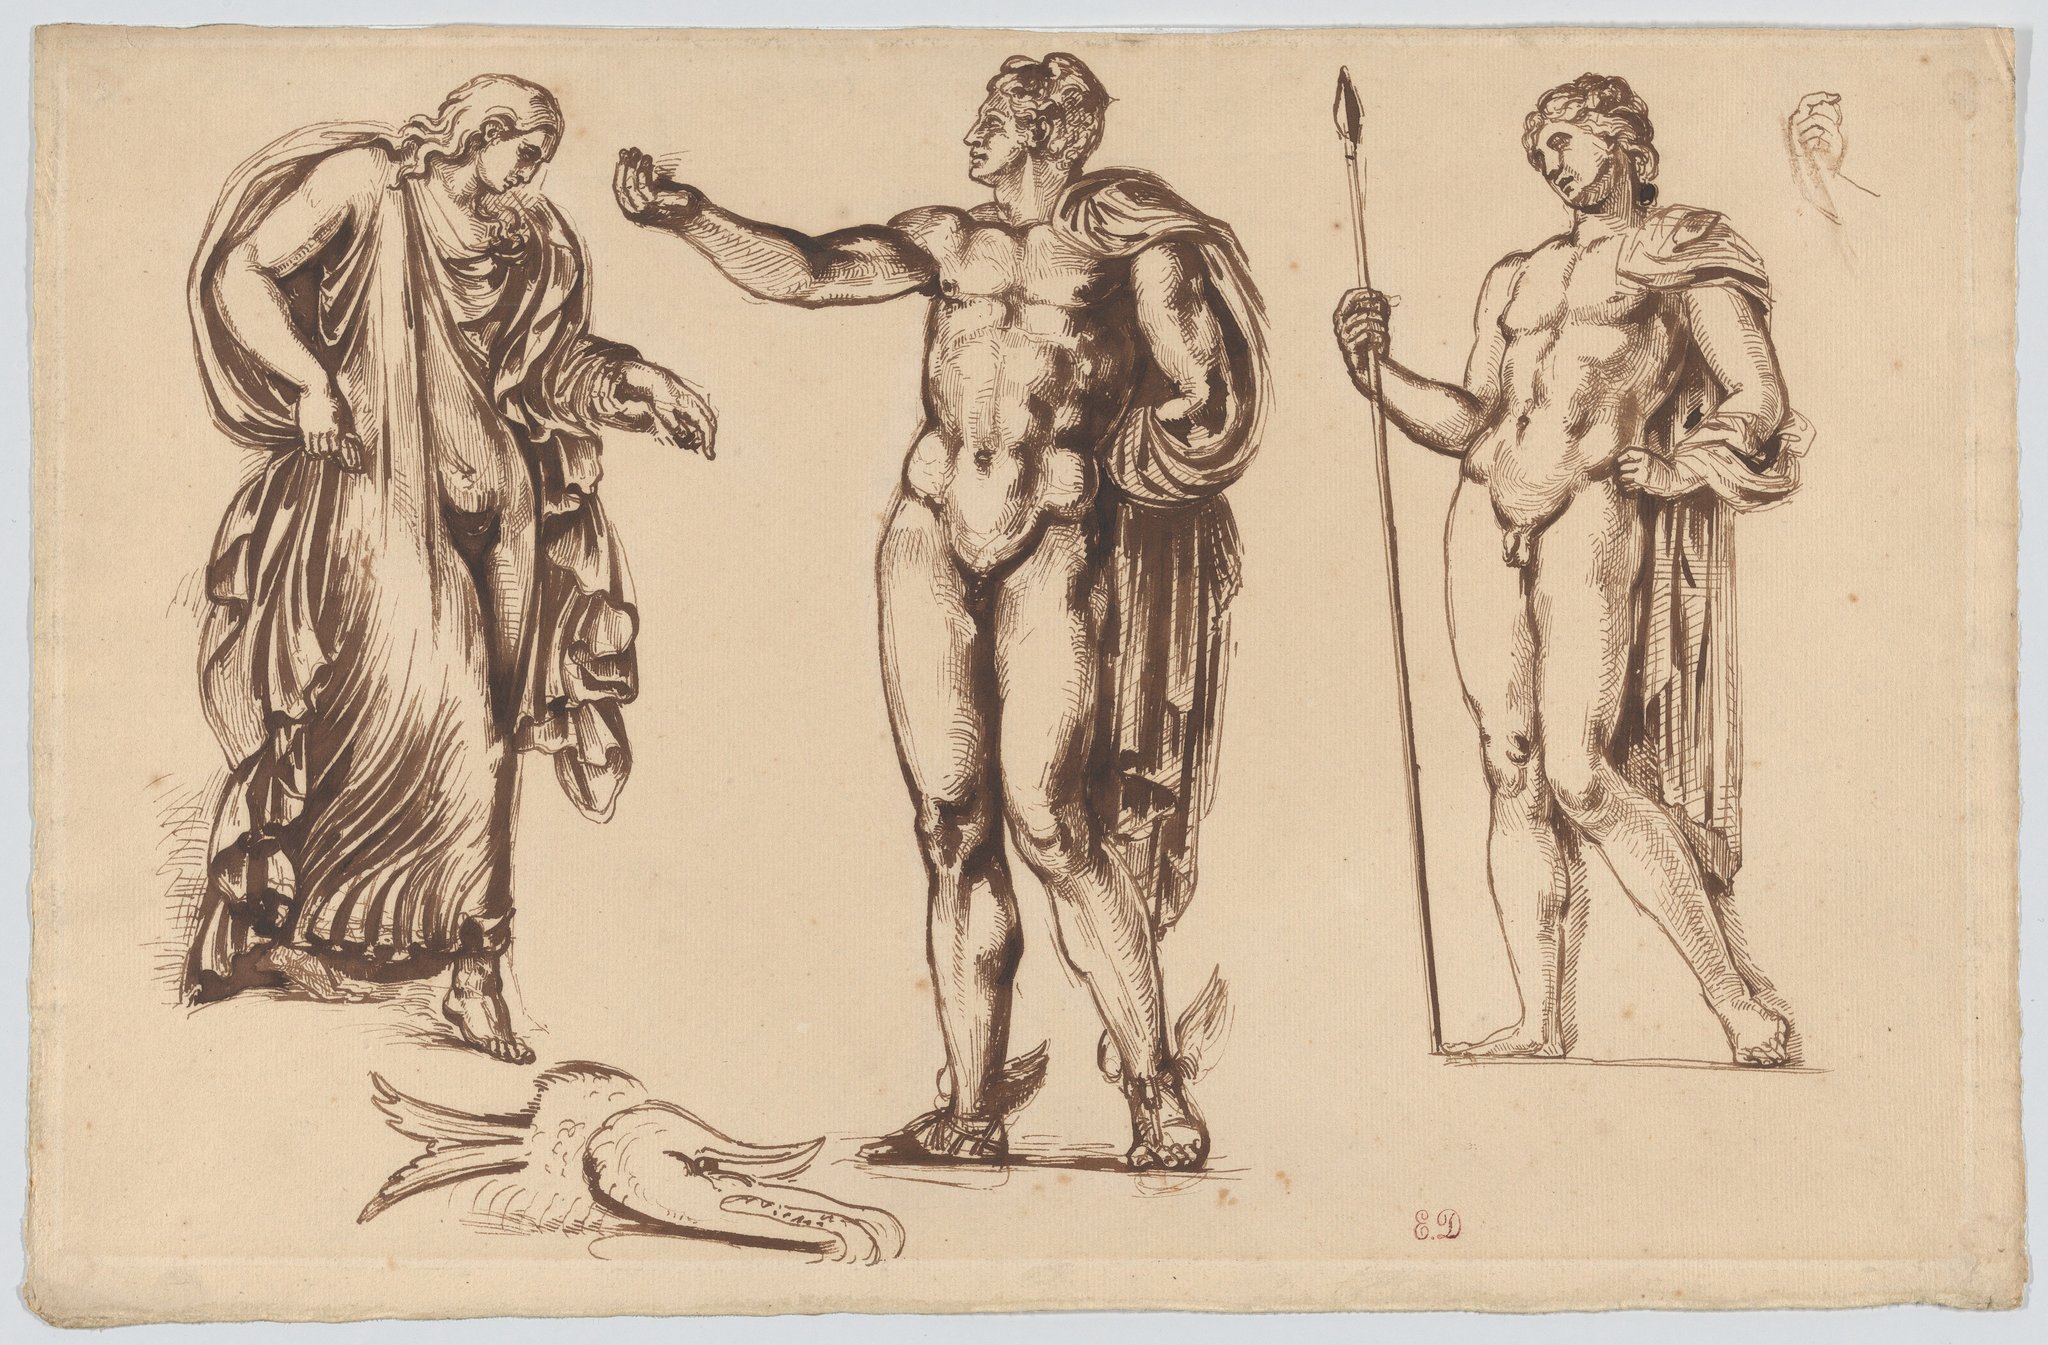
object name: drawing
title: Perseus, Andromeda, and Apollo, after Bartoli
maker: eugène delacroix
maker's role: artist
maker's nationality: french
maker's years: 1798-1863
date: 1822-1826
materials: ink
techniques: pen